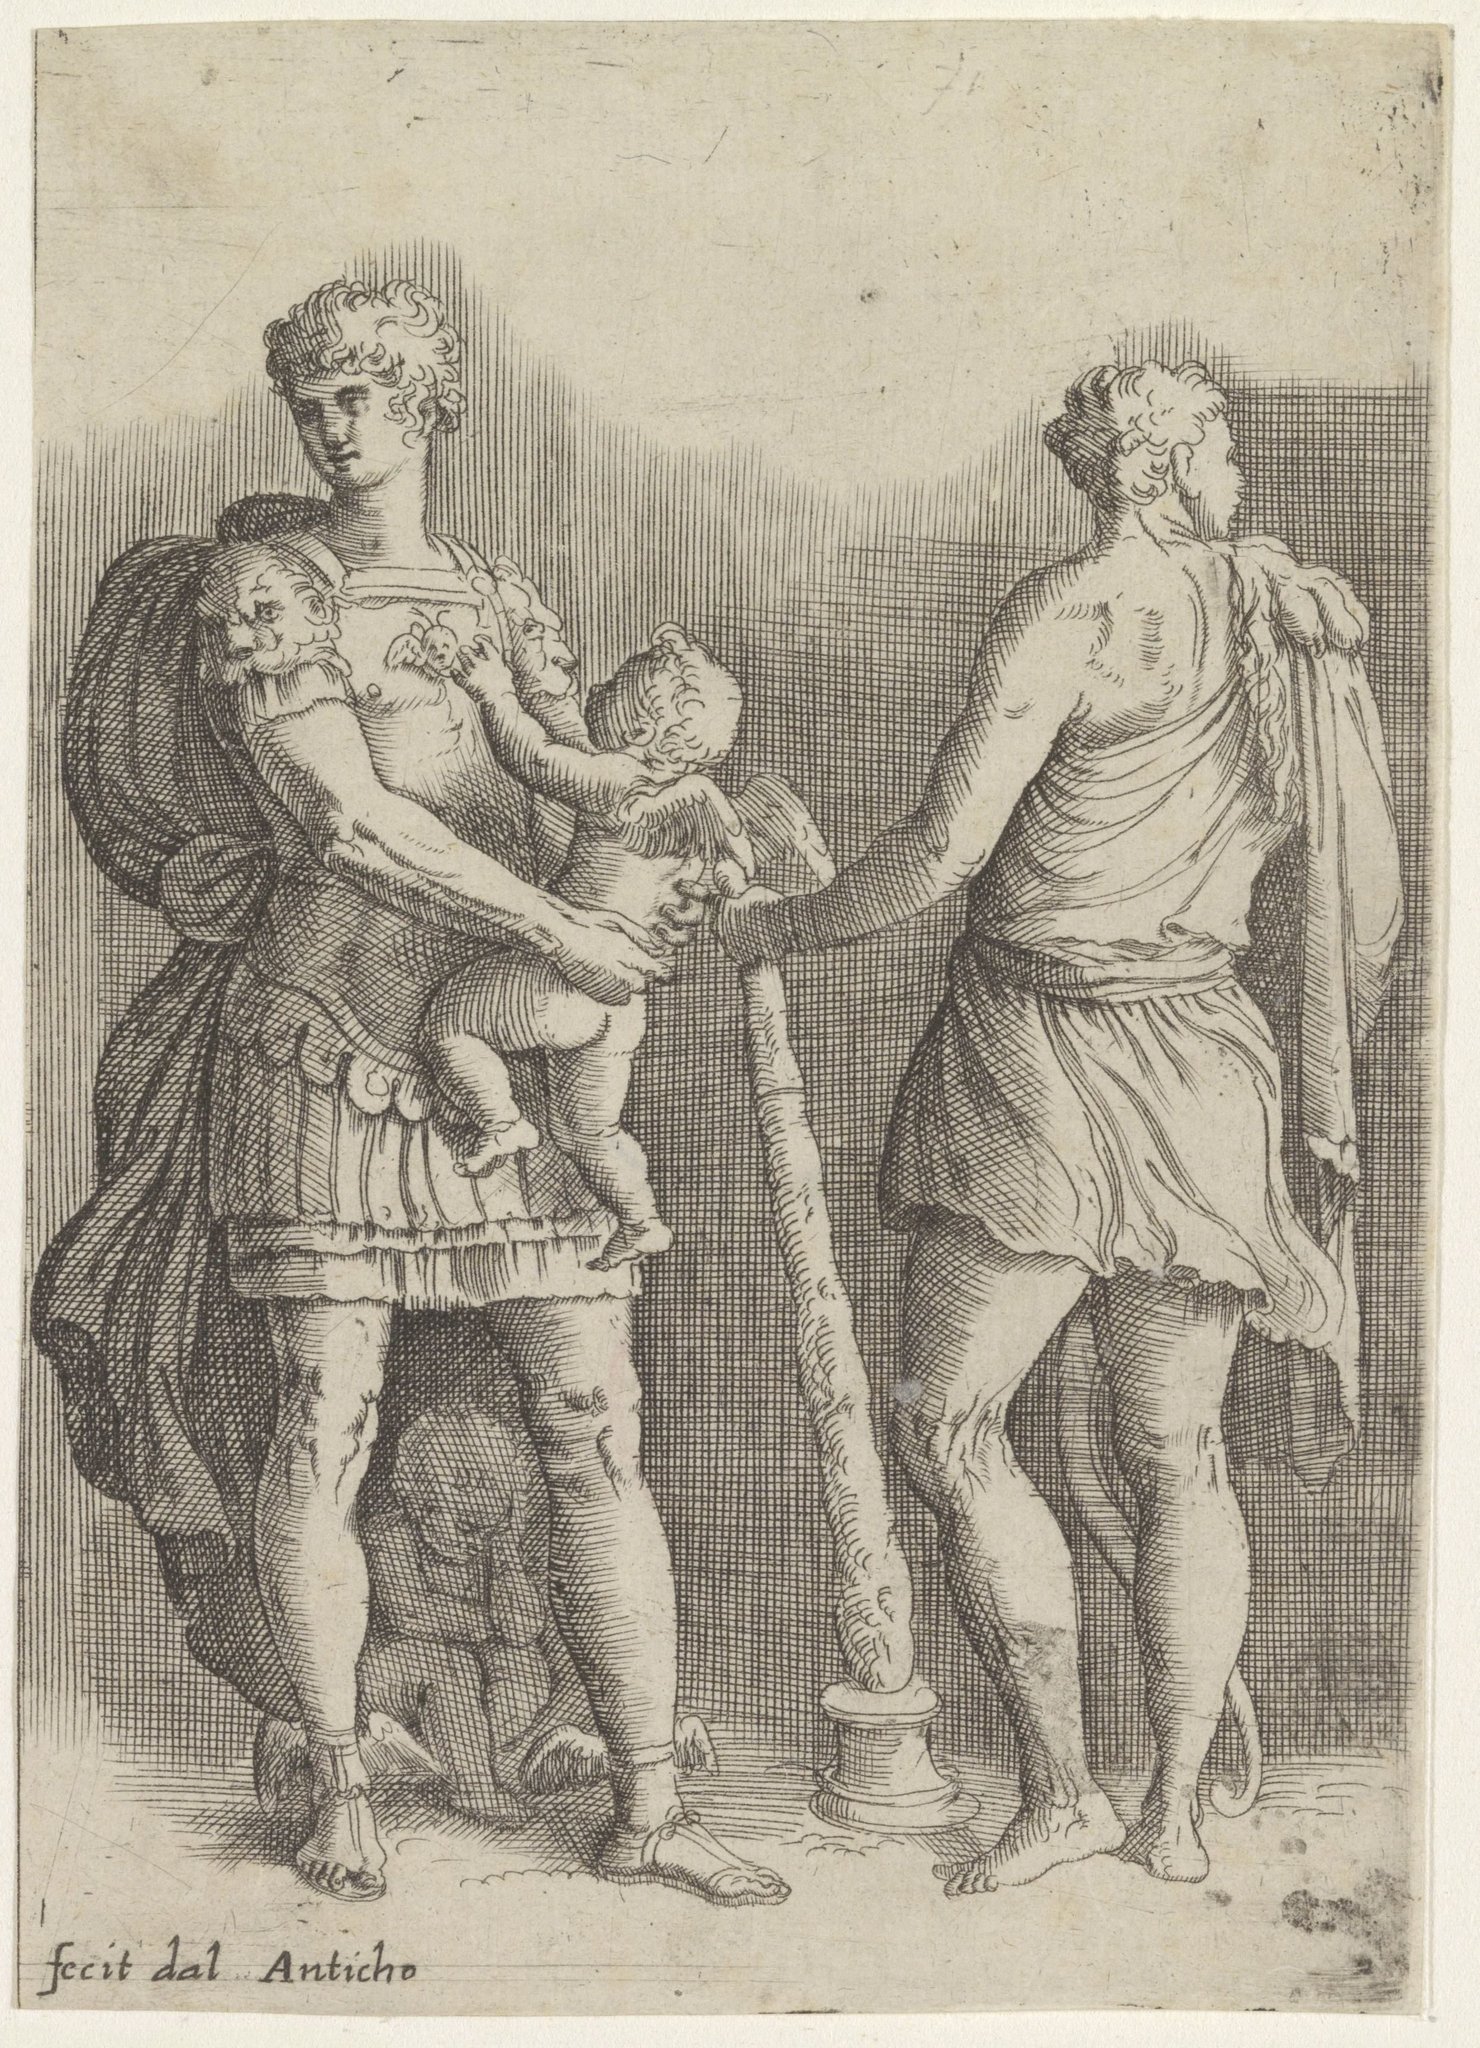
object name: print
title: Perseus met twee putti en Hercules, op de rug gezien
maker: battista franco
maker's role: draughtsman, painter, print maker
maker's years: 1510-1561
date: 1520-1561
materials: paper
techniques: etching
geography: italy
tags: (story of) hercules (heracles), cupids: 'amores', 'amoretti', 'putti', (story of) perseus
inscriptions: collector's mark: Lugt 2228, collector's mark: Lugt 2641b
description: Perseus met twee putti en Hercules, op de rug gezien. Rechterhelft van een versneden prent.